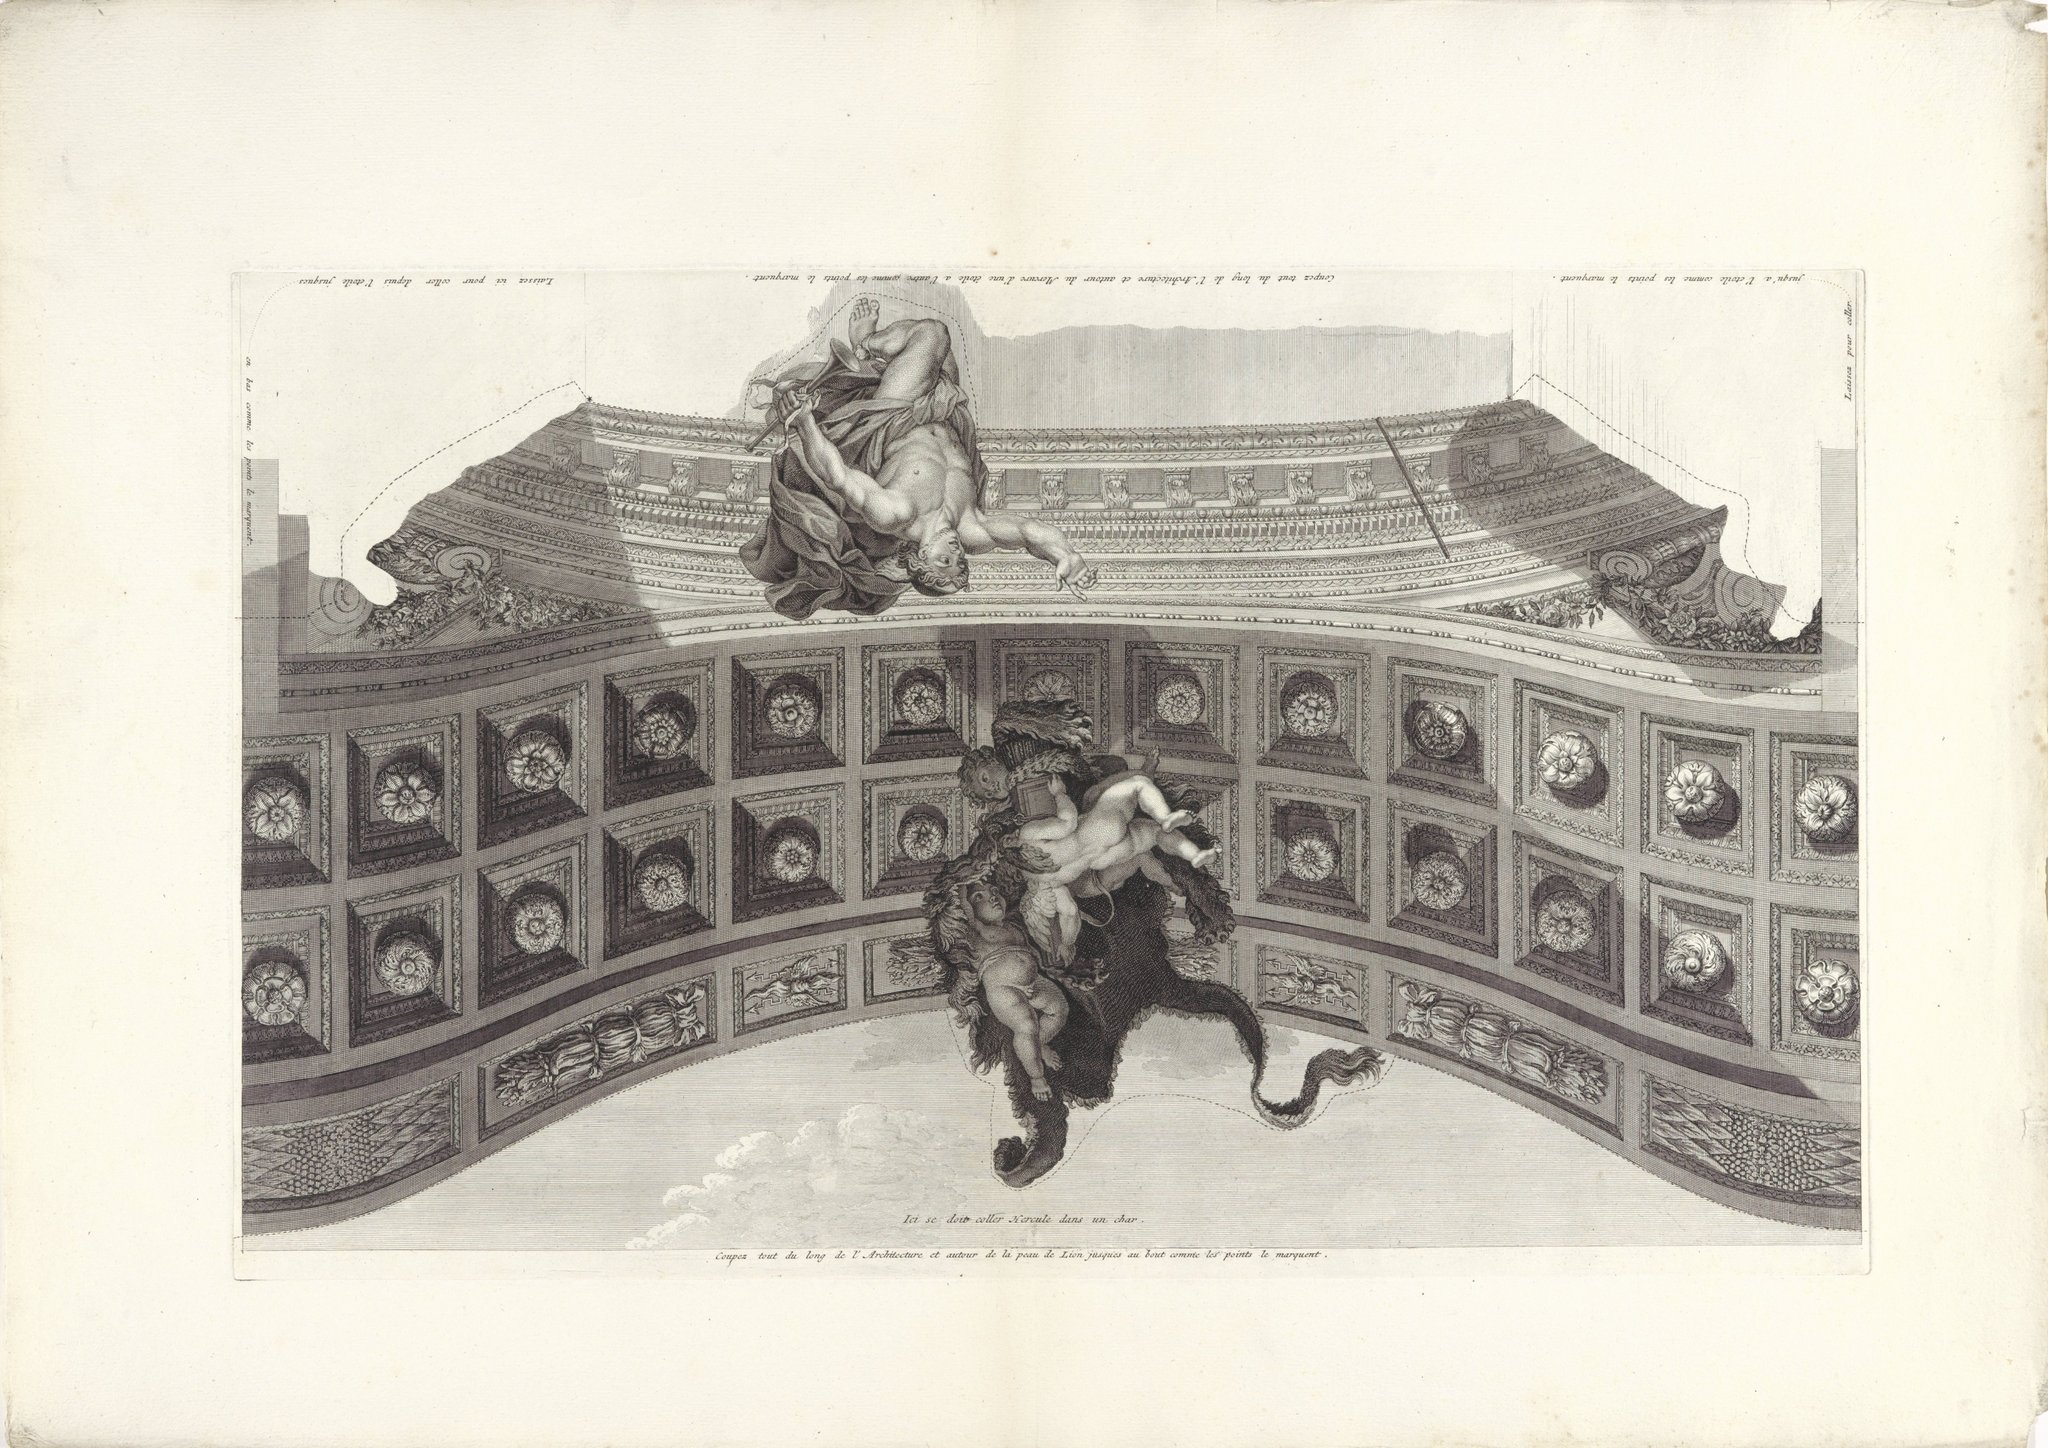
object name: print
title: La galerie de monsr. le president Lambert representant l'Apotheose d'Hercule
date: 1713-1719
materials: paper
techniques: engraving, etching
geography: paris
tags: hercules skins the lion and clothes himself with its skin (+ variant), (story of) mercury (hermes), (decorated) ceiling, cupids: 'amores', 'amoretti', 'putti'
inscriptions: collector's mark: Lugt 2228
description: Mercurius, de boodschapper van de goden, komt aanvliegen met een trompet in zijn hand. Putti dragen de huid van de door Hercules overwonnen Nemeïsche leeuw. Langs de randen instructies voor het monteren van de prent aan andere prenten. Prent maakt deel uit van een serie prenten, die samen het geschilderde plafond met de Apotheose van Hercules in het Hôtel Lambert te Parijs voorstellen.